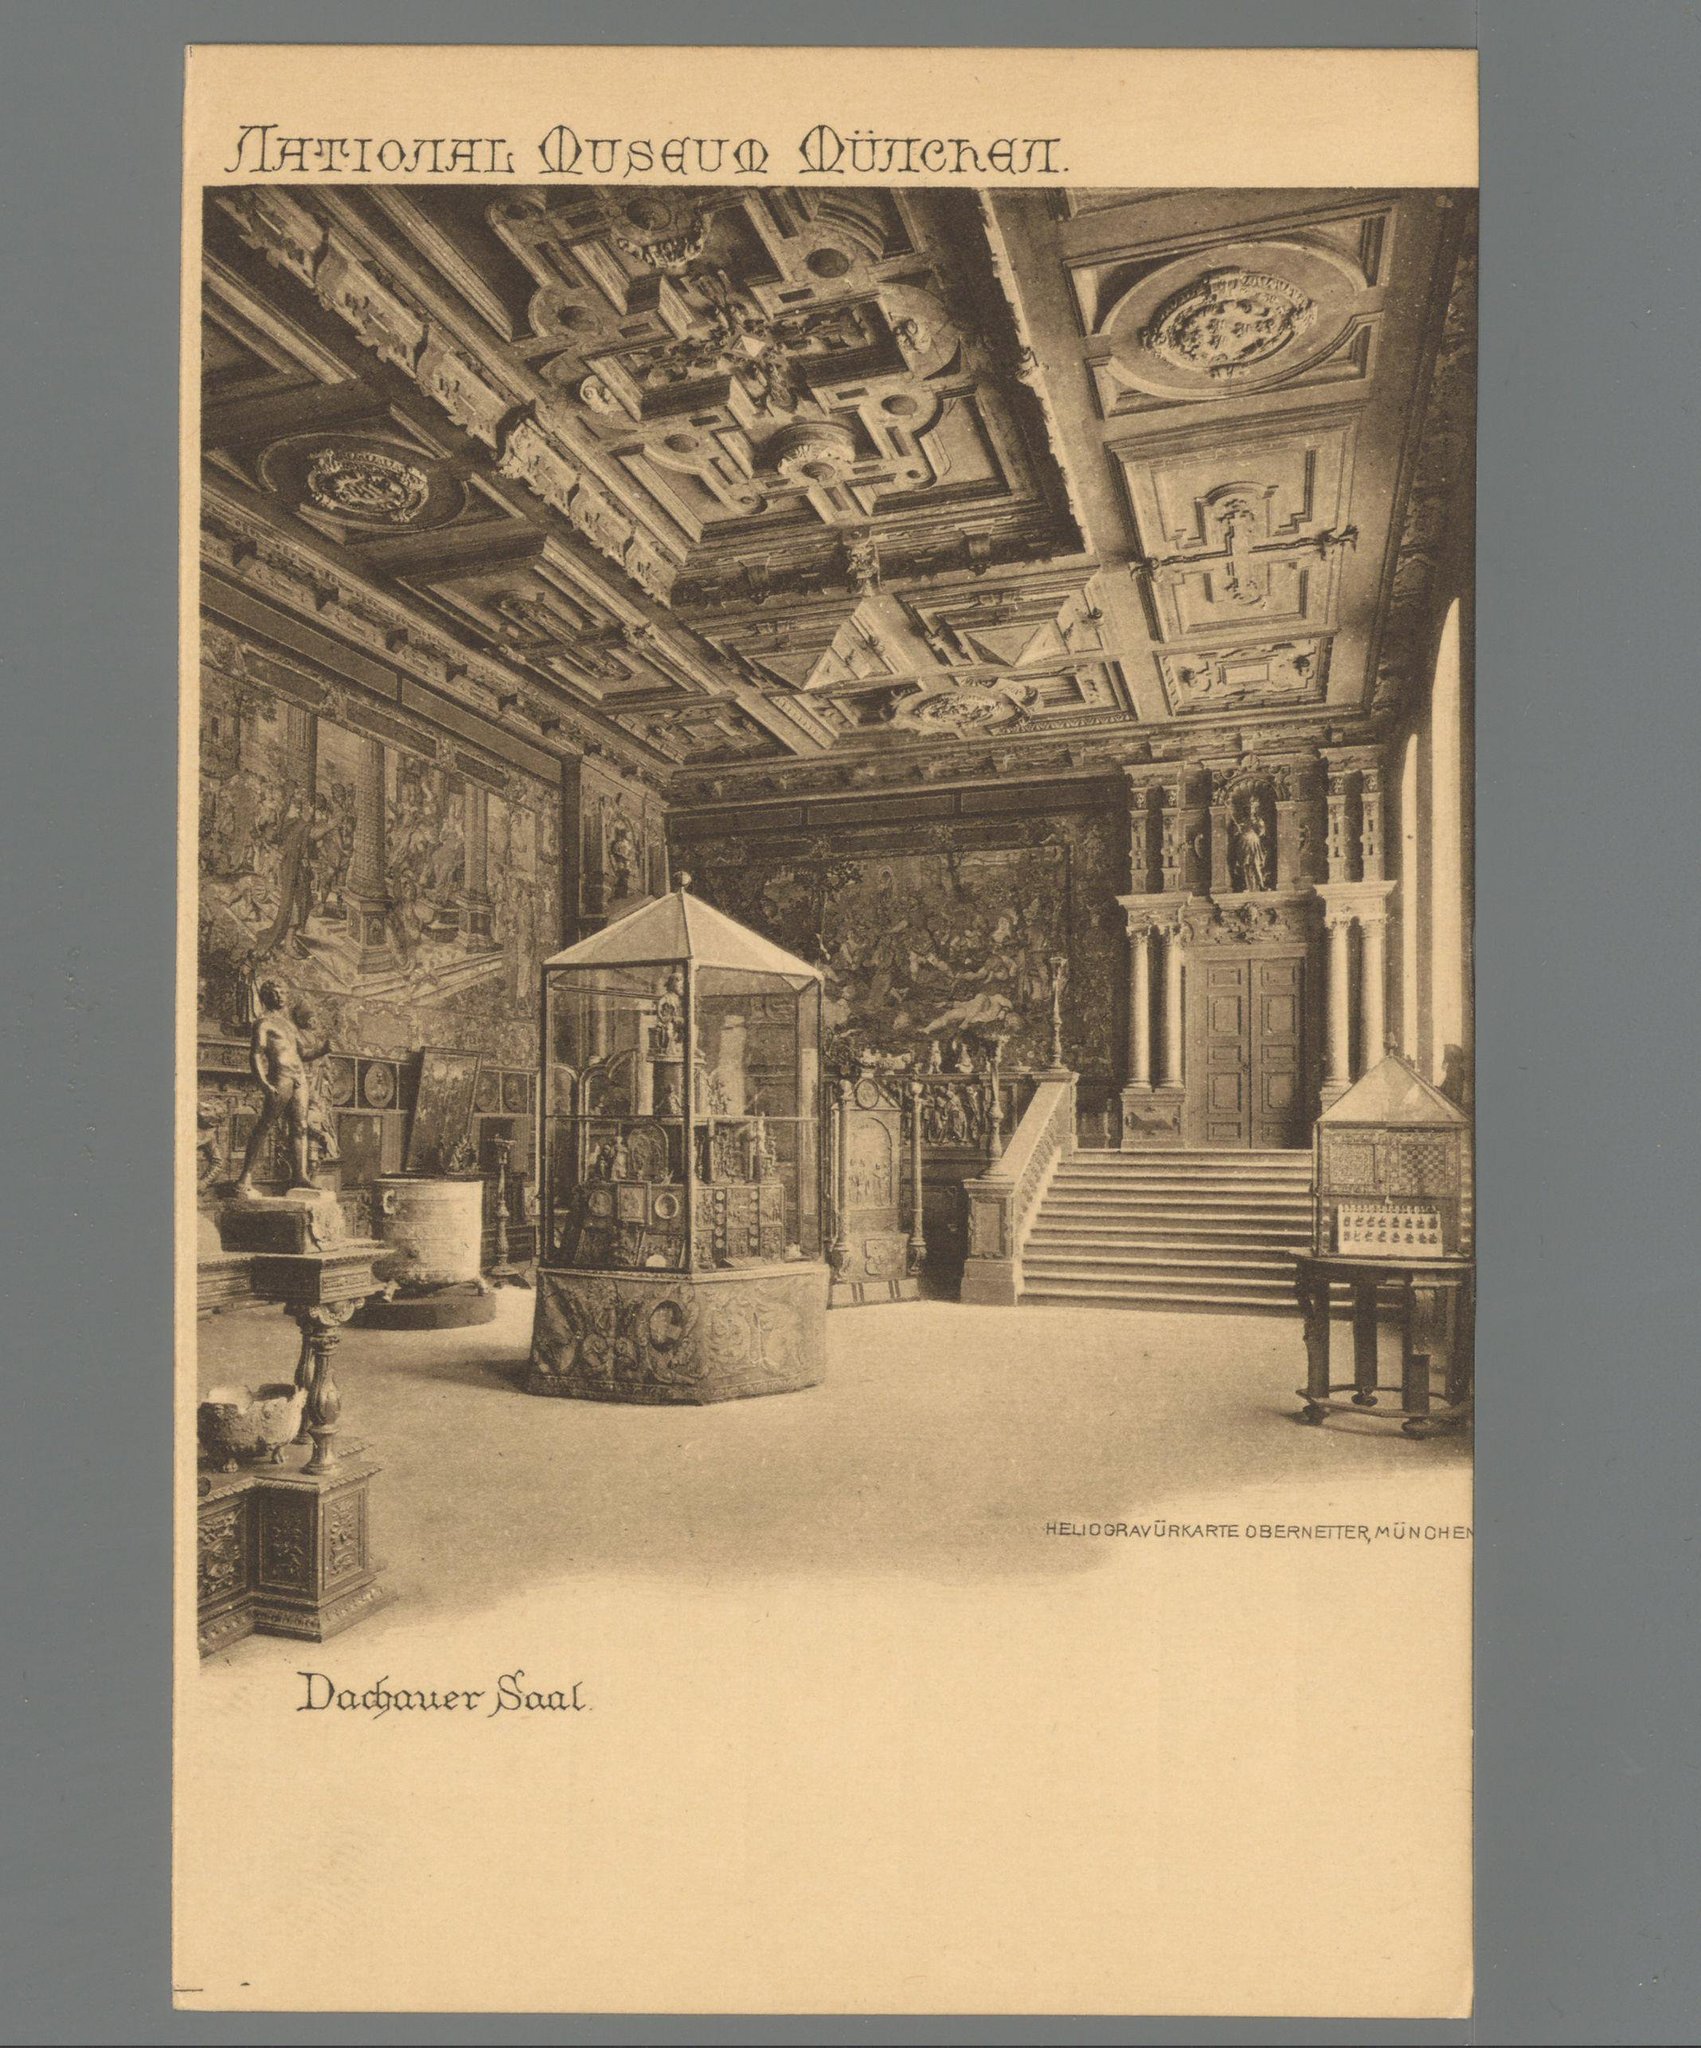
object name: photomechanical print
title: National Museum München. Dachauer Saal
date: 1885-1905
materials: cardboard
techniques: photoaquatint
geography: munich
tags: permanent exhibition, museum